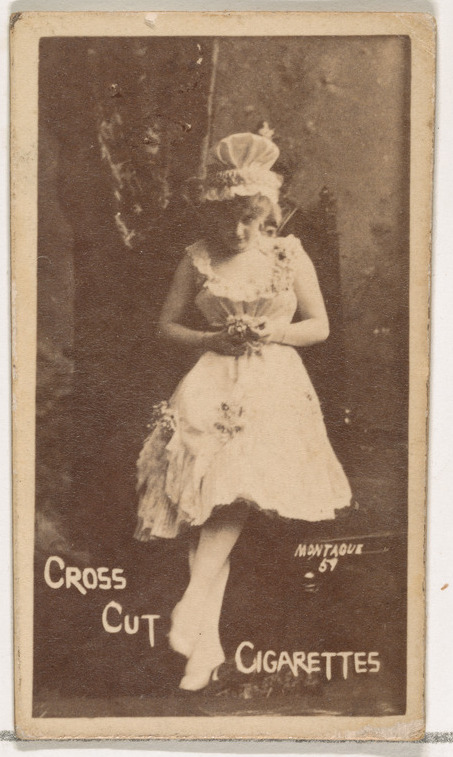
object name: print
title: Card Number 59, Montague, from the Actors and Actresses series (N145-1) issued by Duke Sons & Co. to promote Cross Cut Cigarettes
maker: w. duke, sons & co.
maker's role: publisher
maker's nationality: american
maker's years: 1870-1920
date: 1880-1889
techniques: albumen silver print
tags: portraits,women,actresses